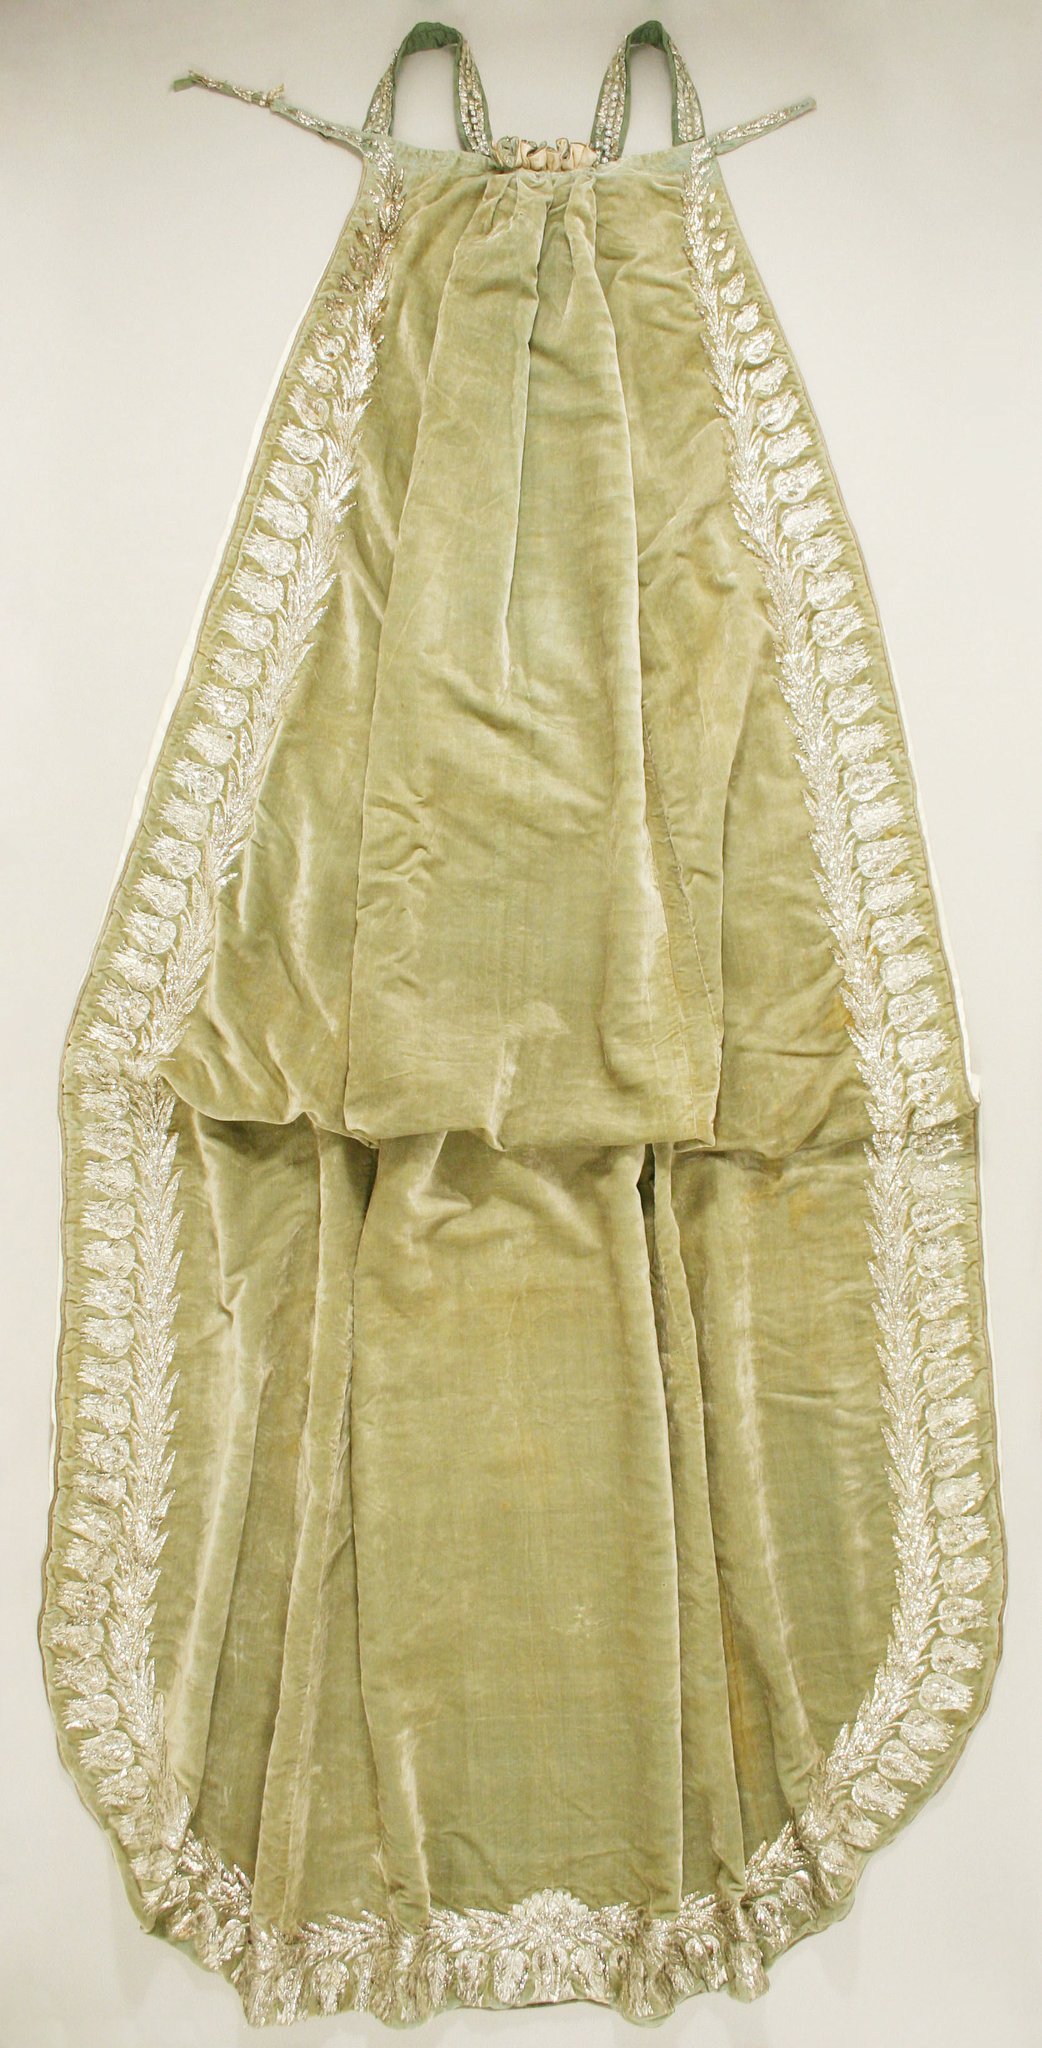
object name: court train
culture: french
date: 1809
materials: silk